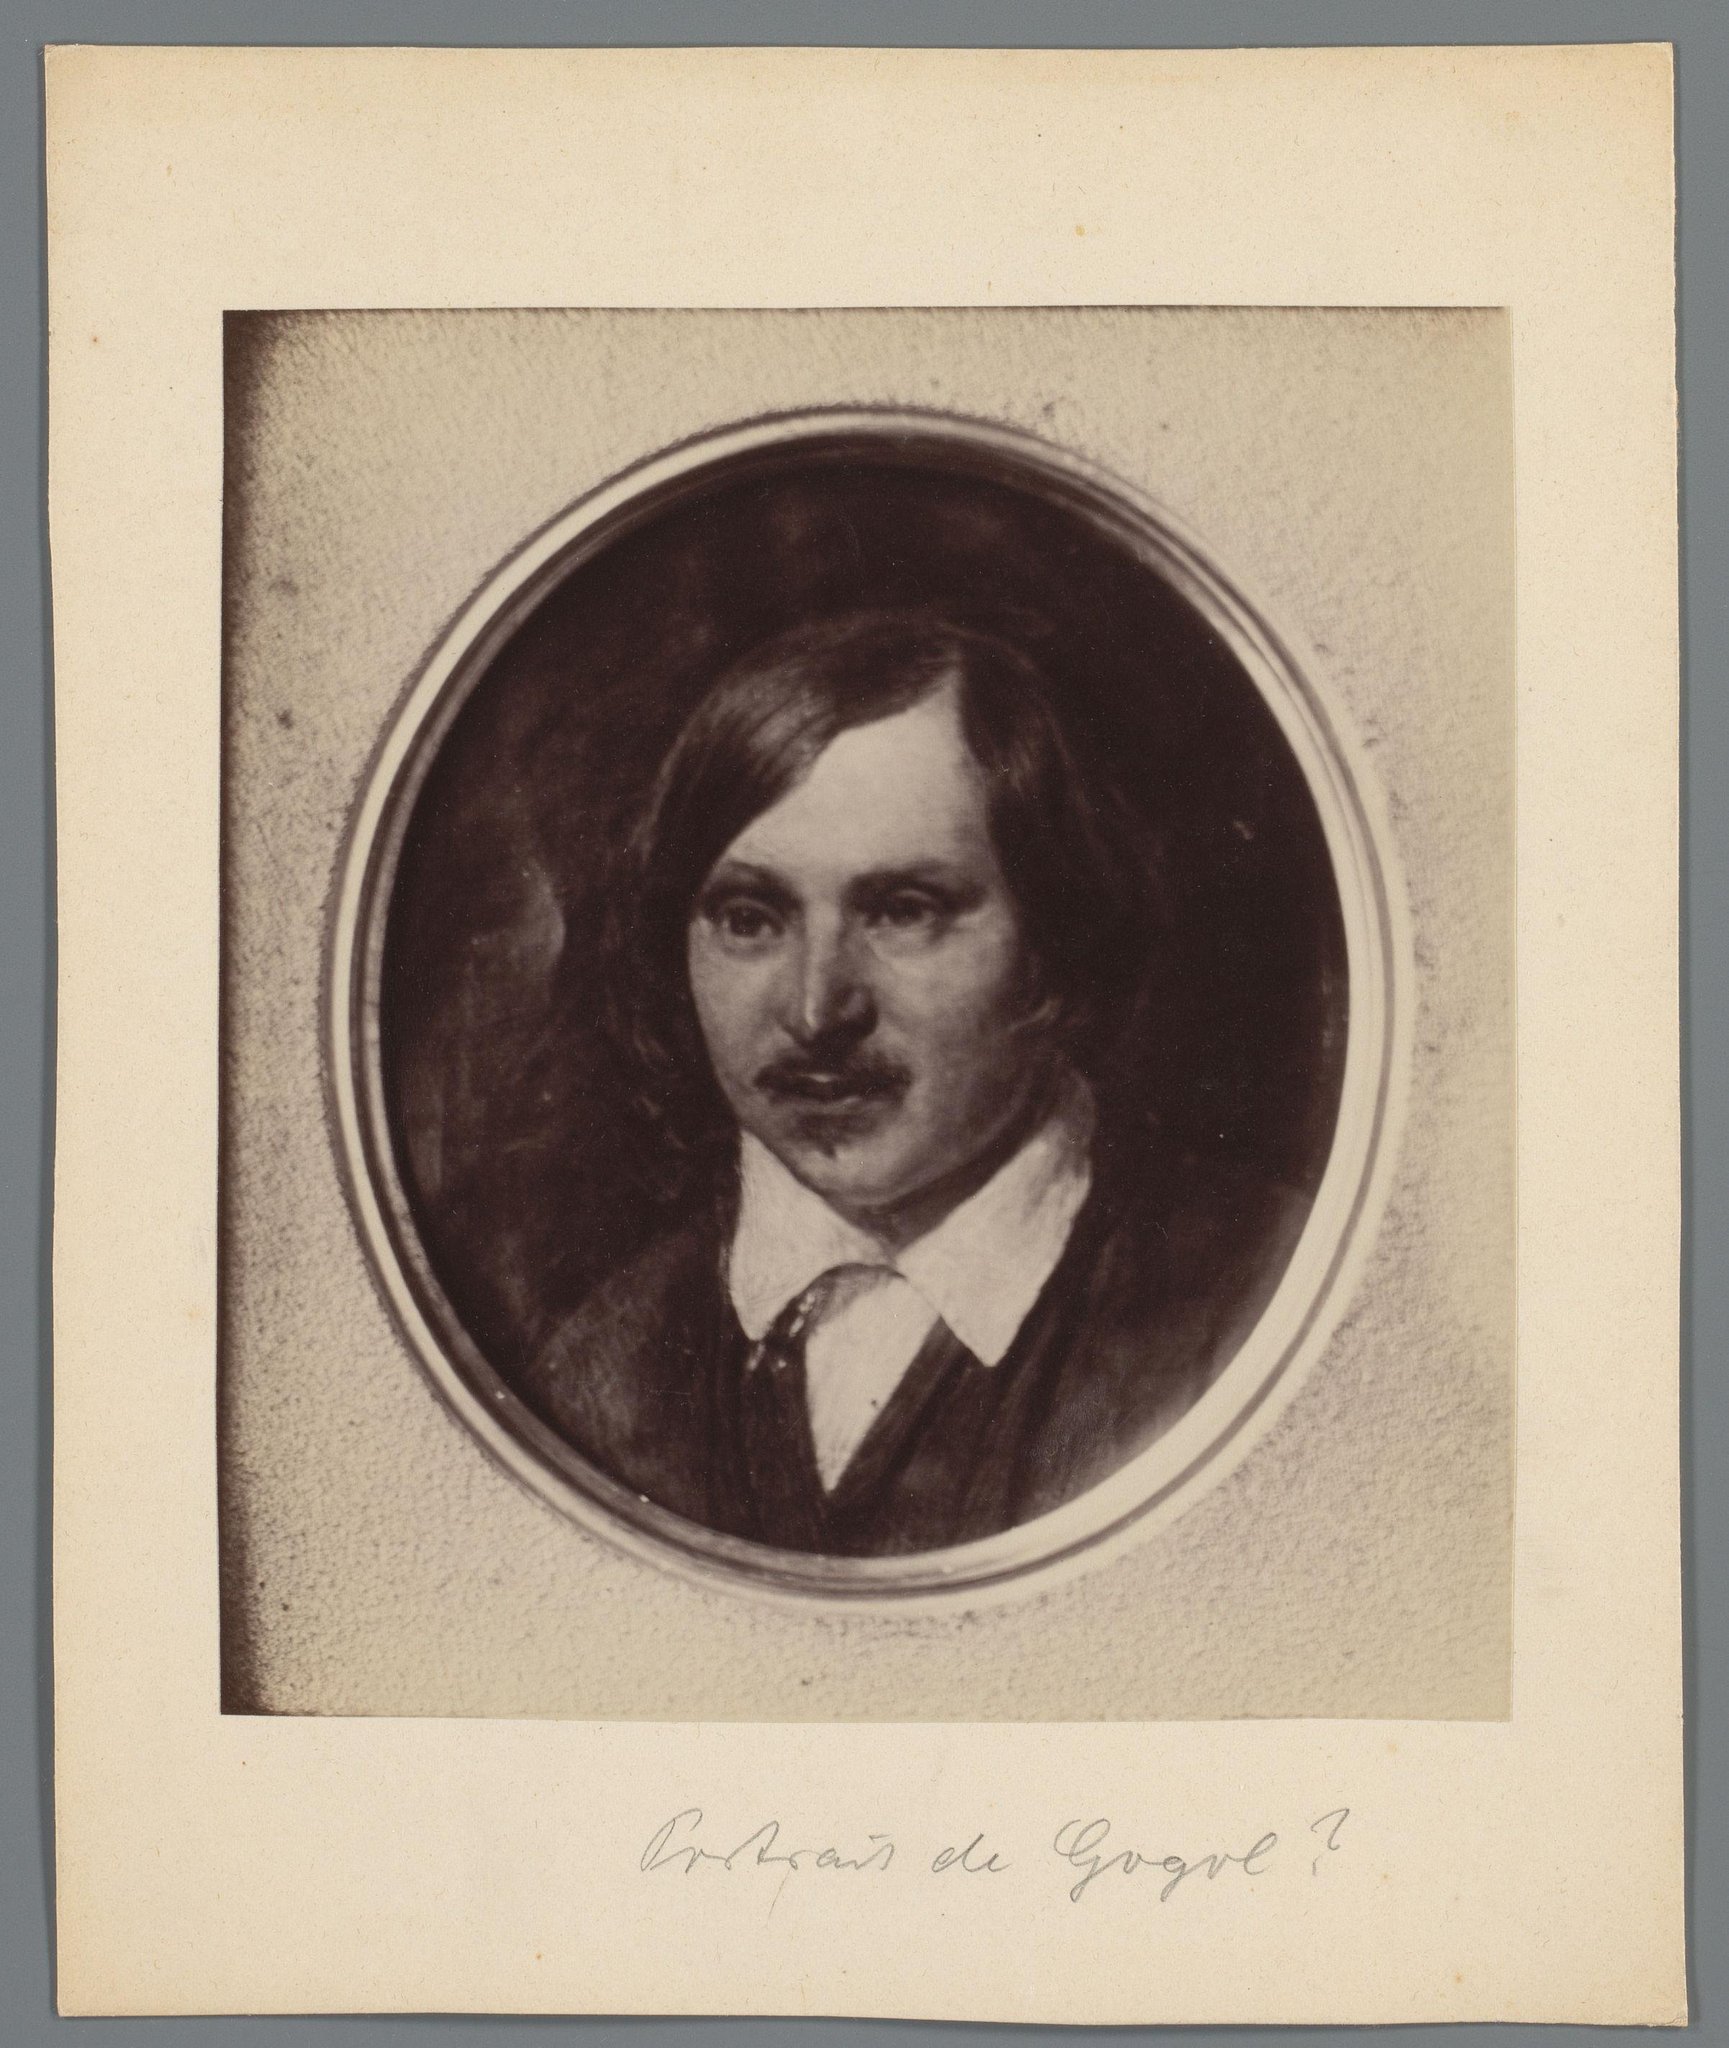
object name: photograph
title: Fotoreproductie van een geschilderd portret van Nikolaj Gogol door Alexander Andrejevitsj Ivanov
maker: Anonymous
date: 1890-1899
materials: cardboard, paper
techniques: albumen print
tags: nikolaj vasil'evic gogol, historical persons, writer, poet, author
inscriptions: inscription: ‘Portrait de Gogol?’